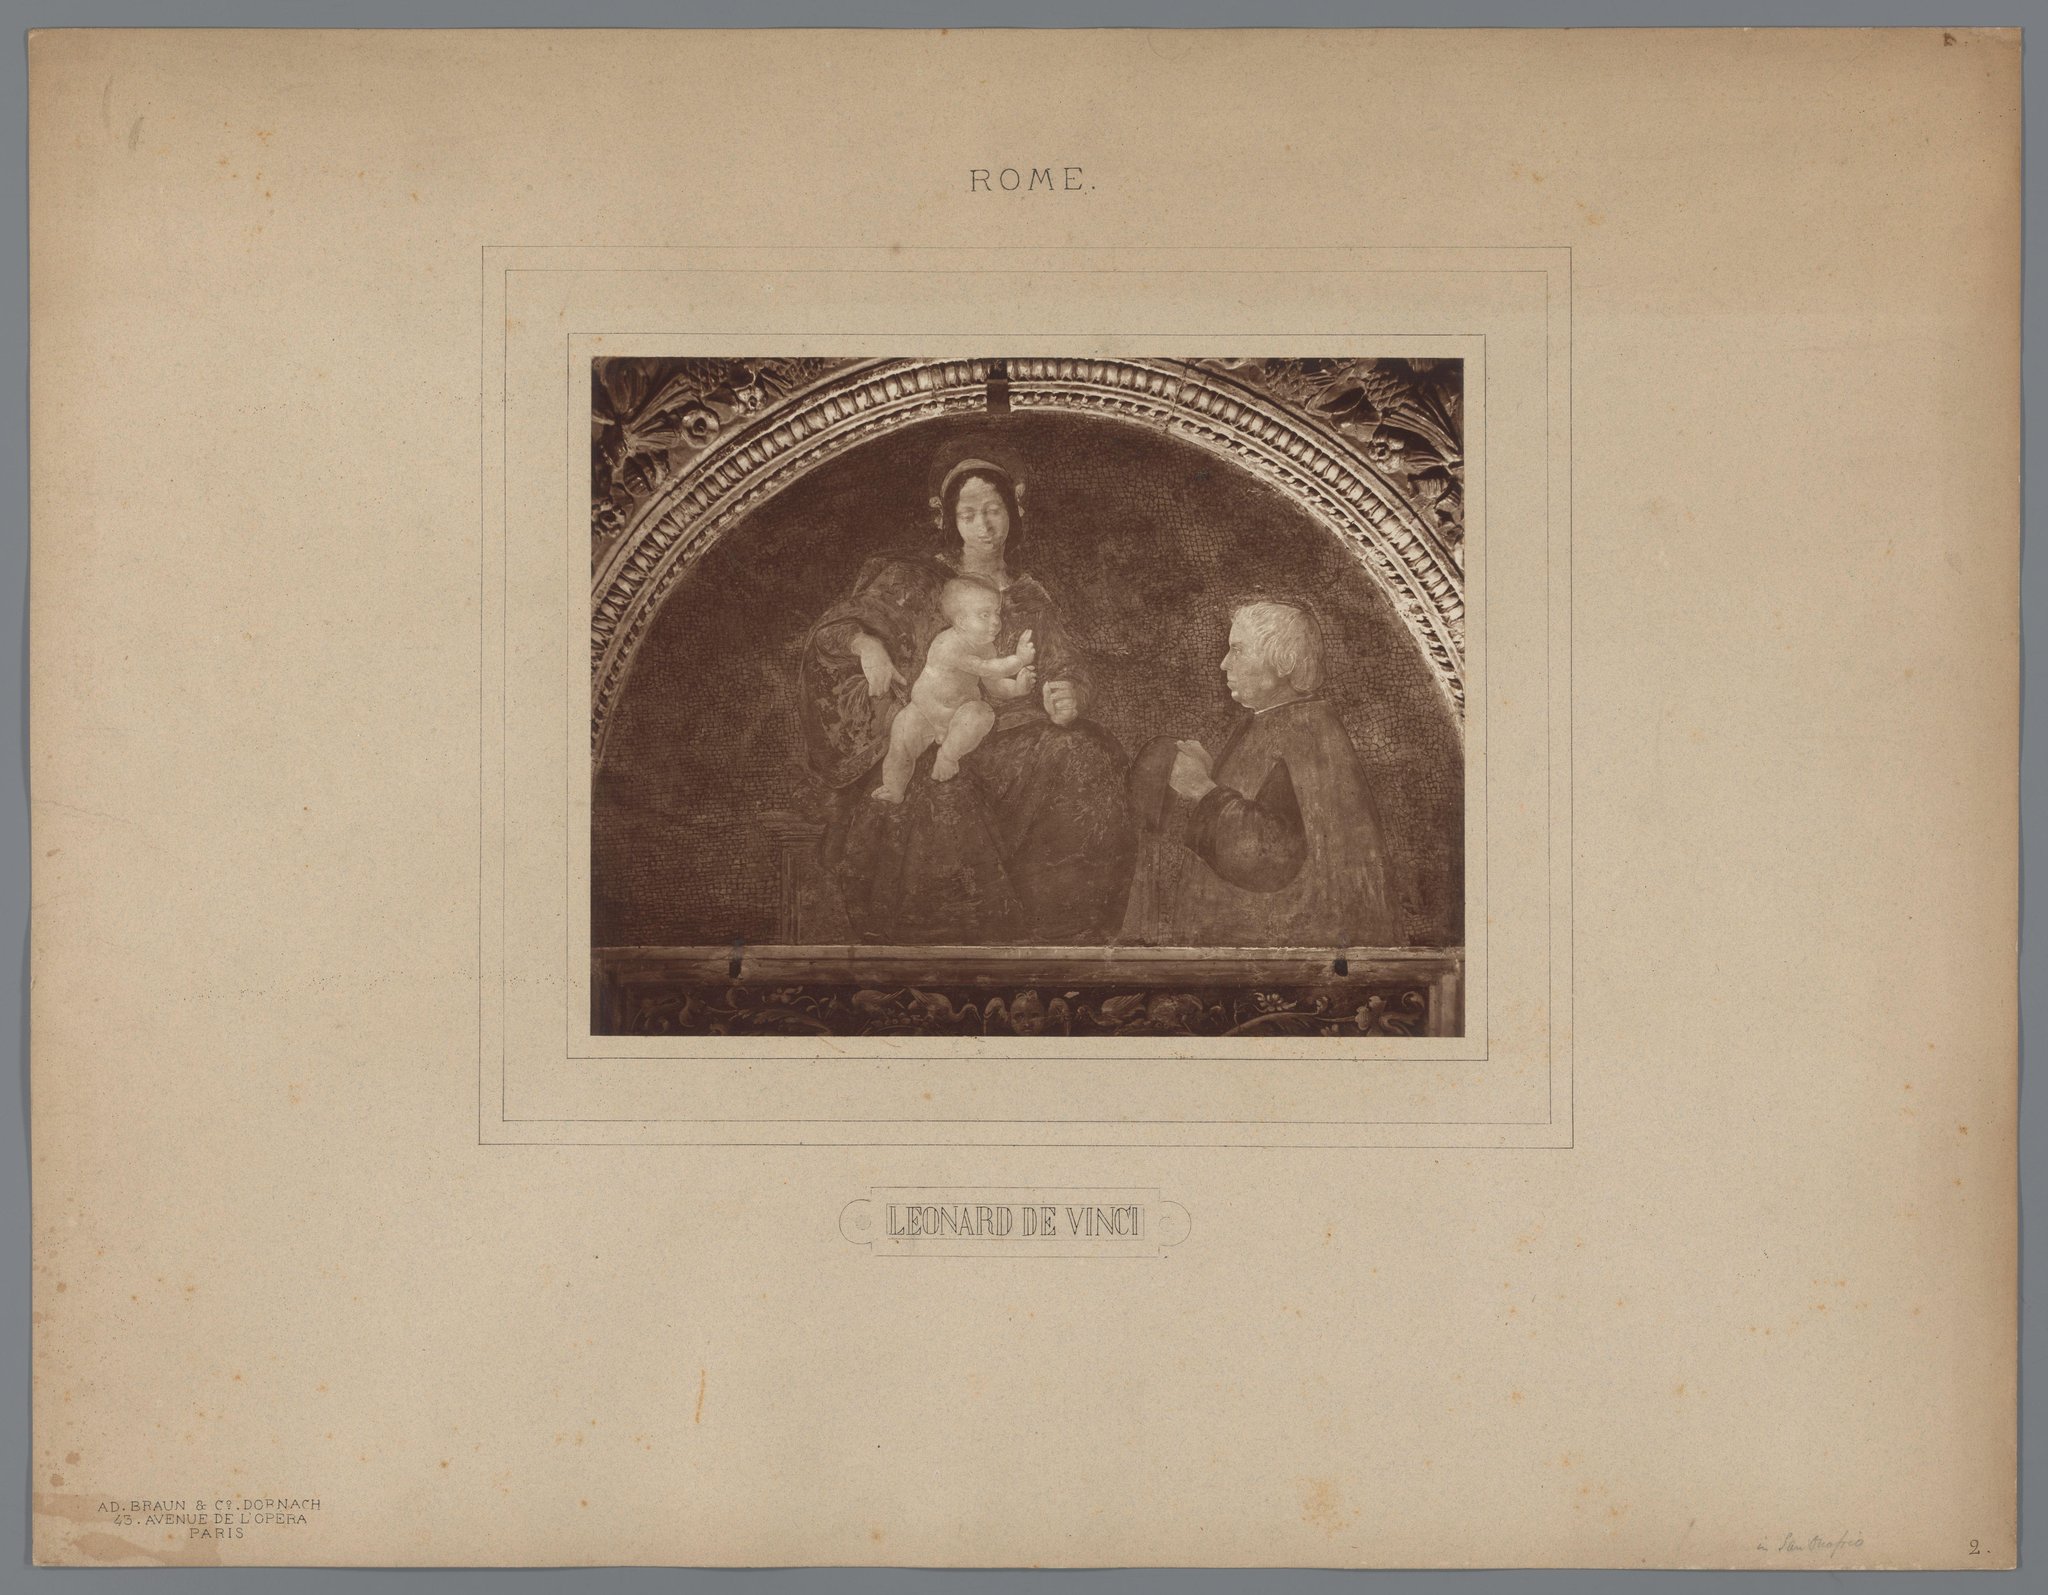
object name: photograph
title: Fotoreproductie van een fresco van Michelangelo van een Madonna met kind en een schenker of heilige (?), Rome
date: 1880-1900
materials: cardboard, paper, photographic support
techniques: carbon print